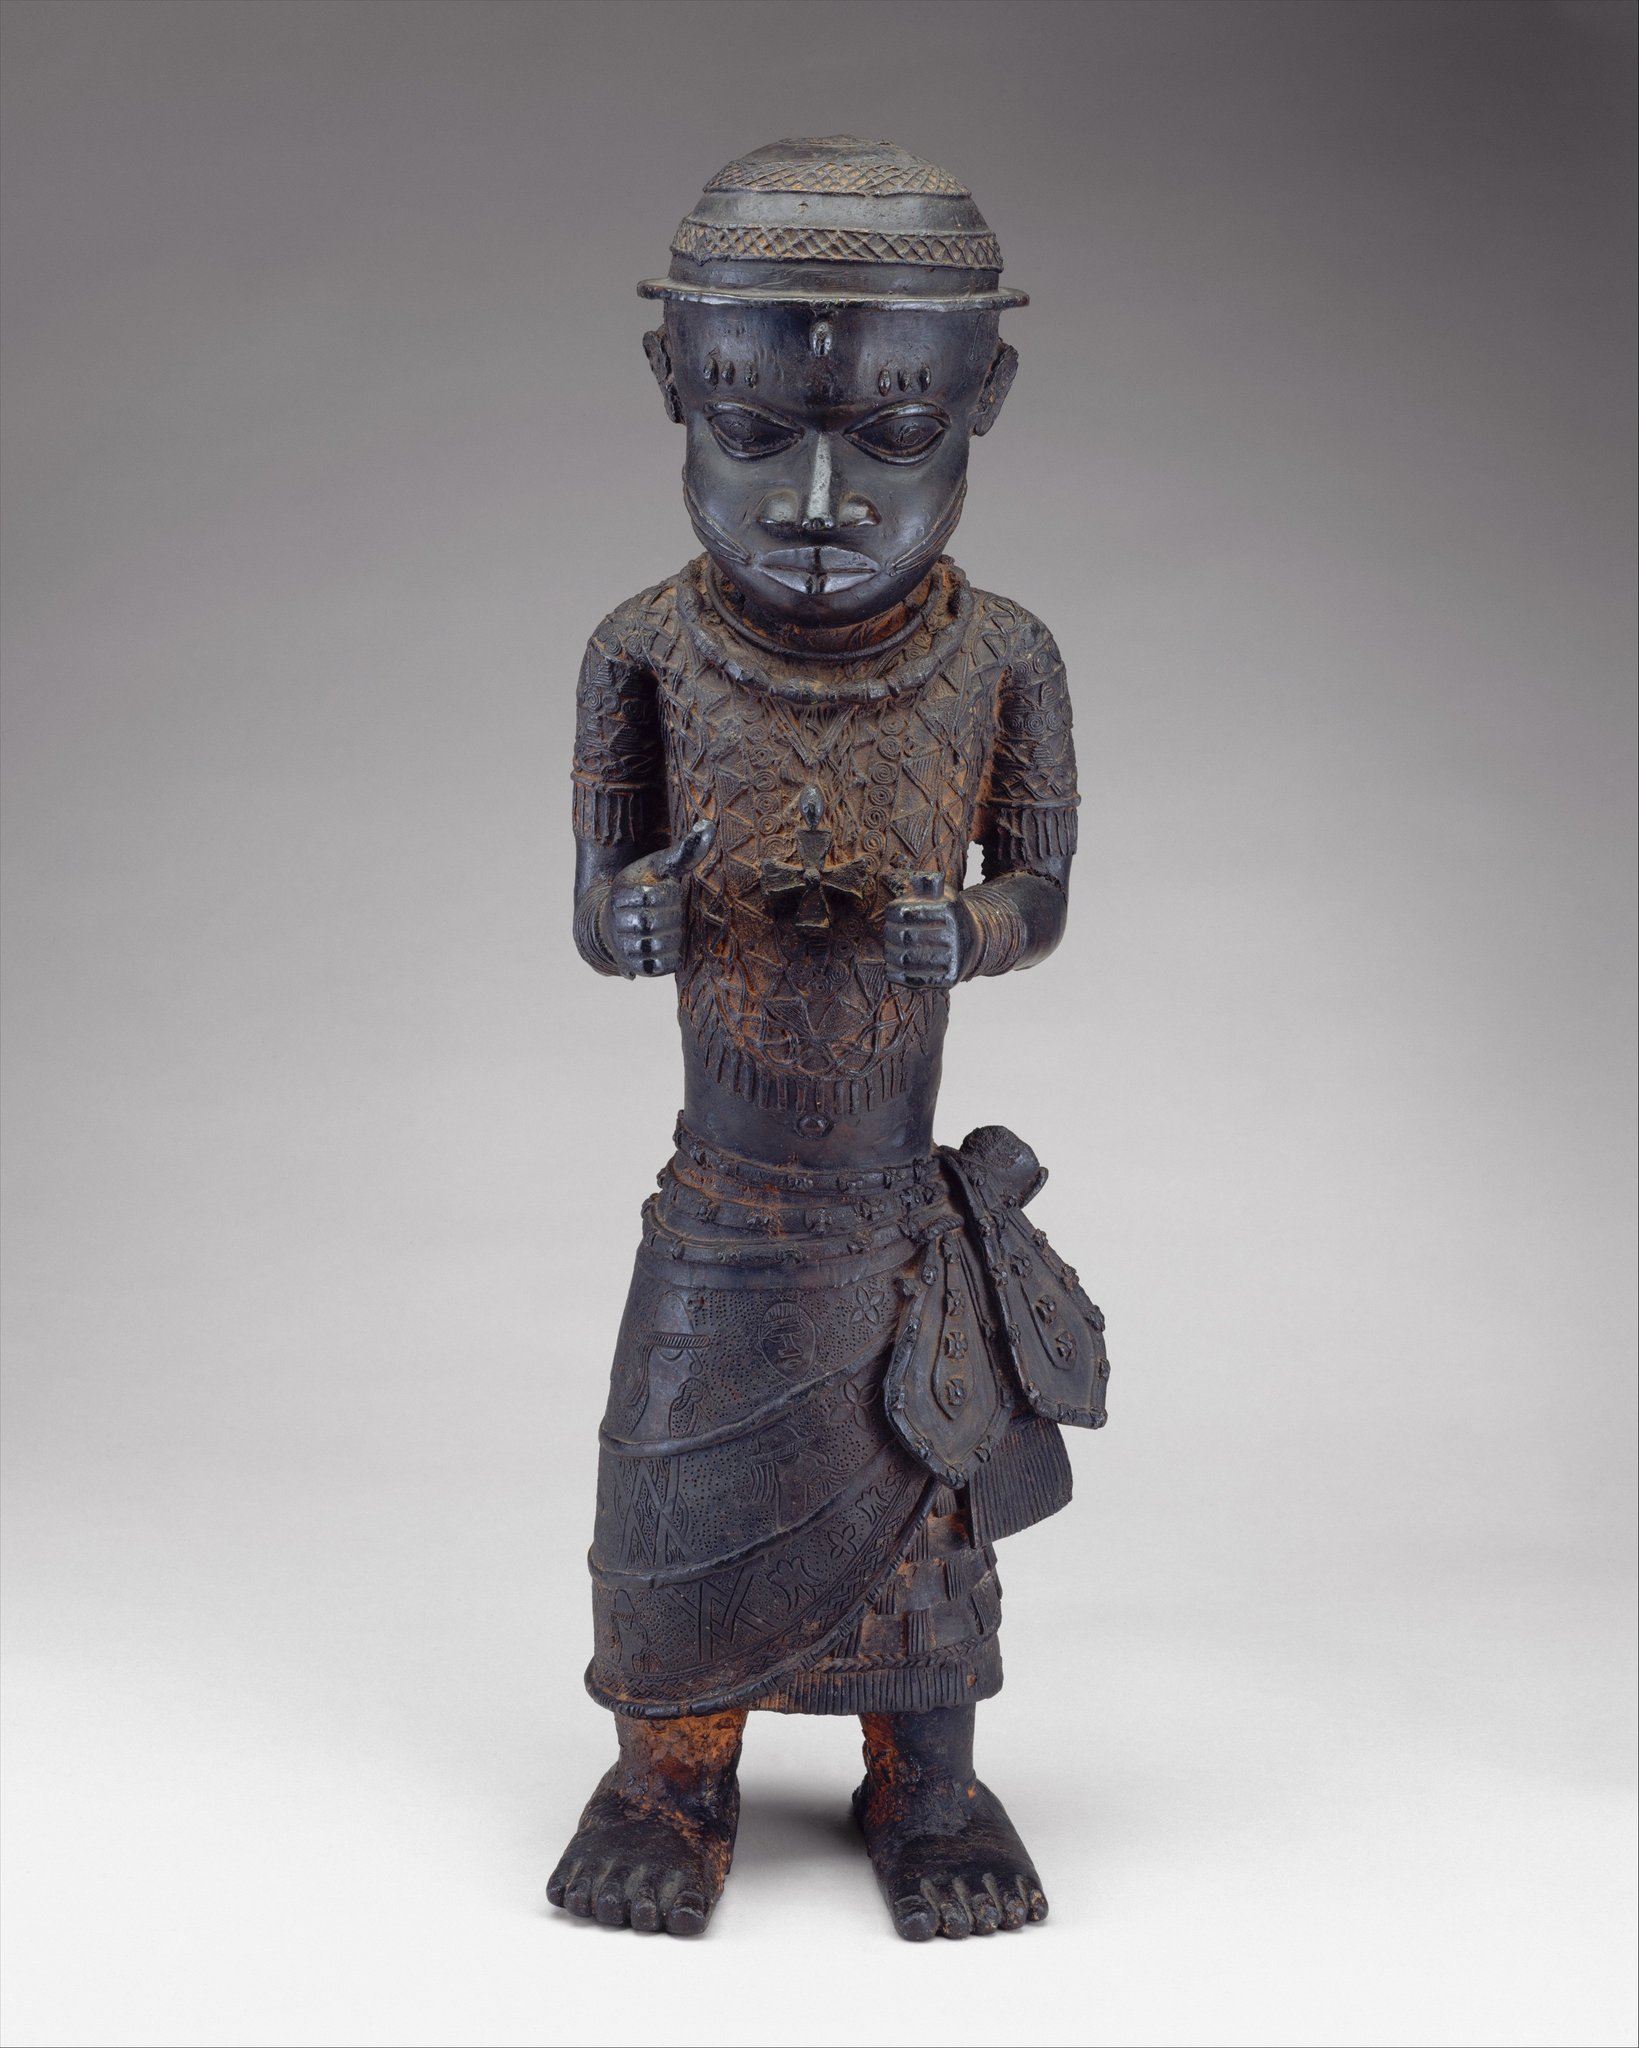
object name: male figure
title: Court official from a commemorative altar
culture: edo period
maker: ìgùn ẹ́rọ̀nwwọ̀n (brass-casting guild) artists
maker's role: artist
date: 1501-1700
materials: brass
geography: nigeria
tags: men